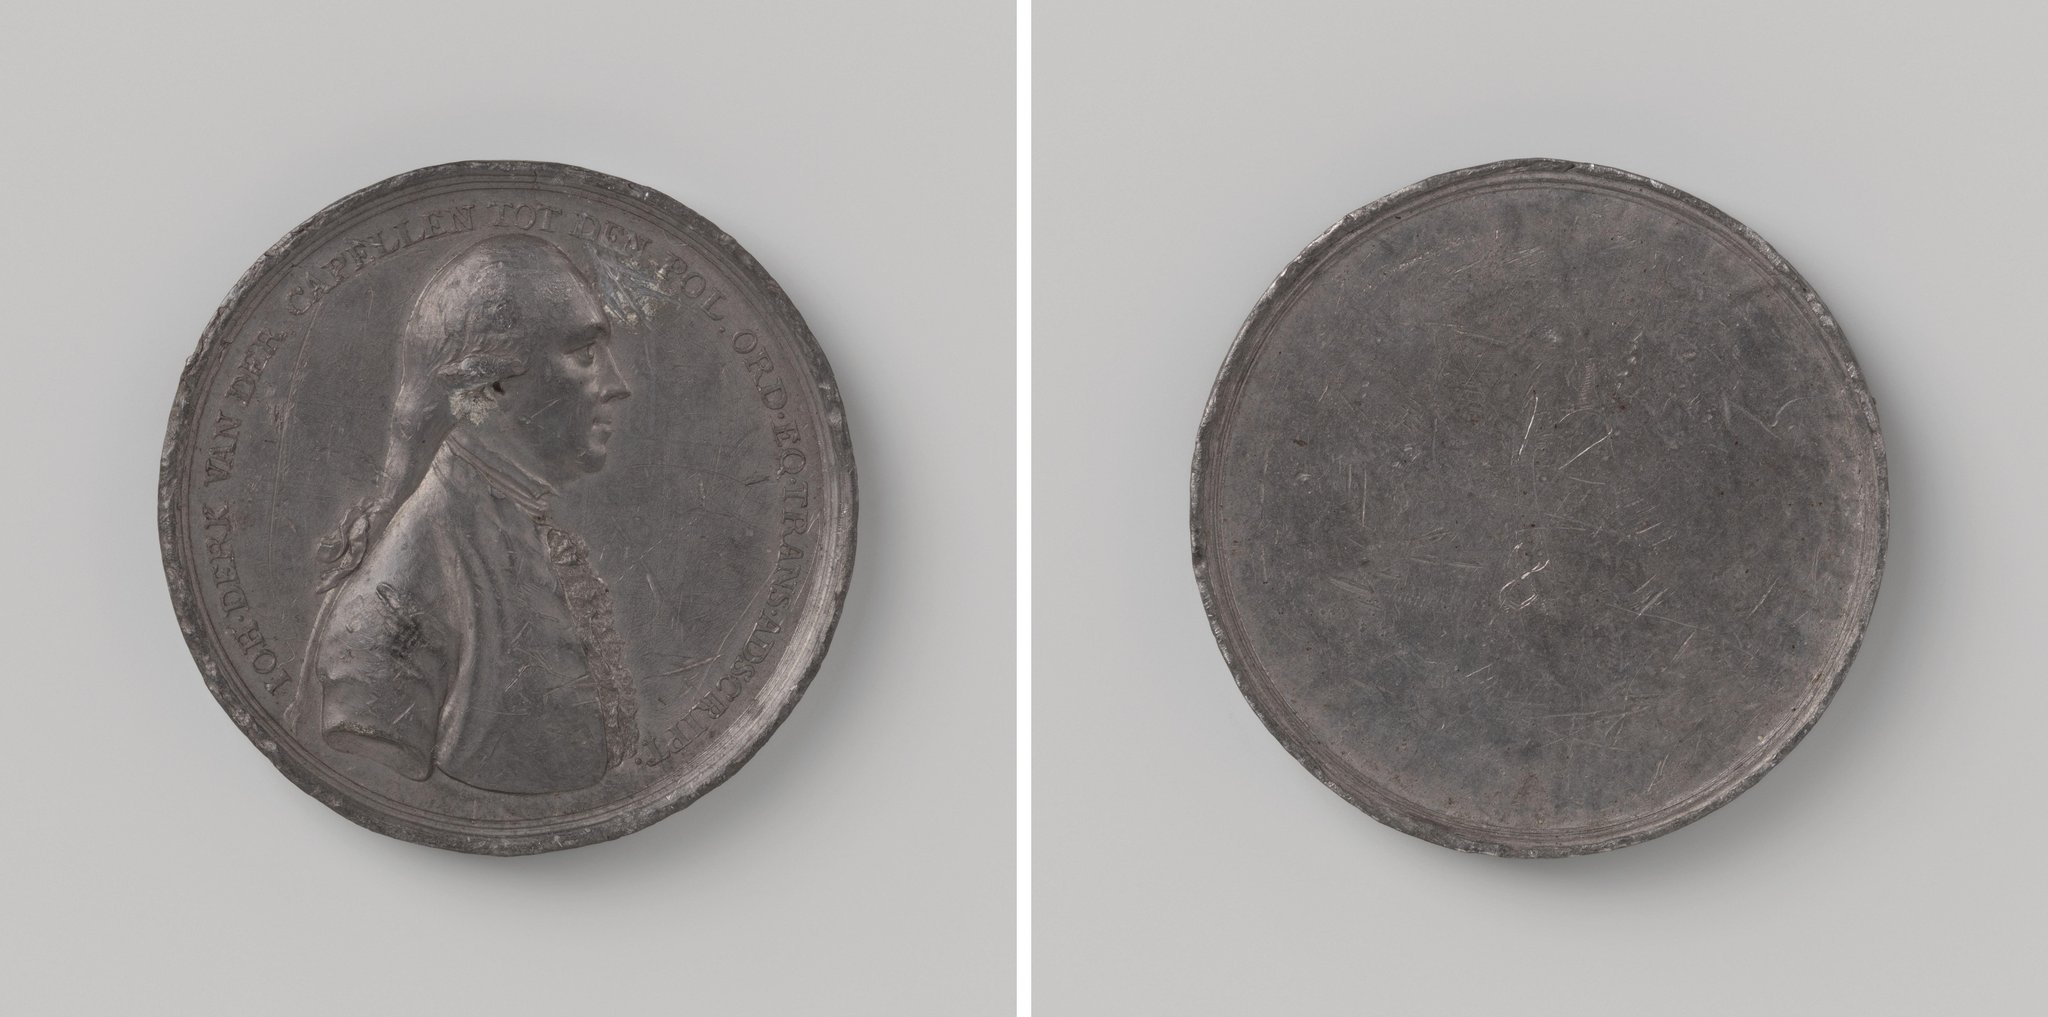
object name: history medal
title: Joan Derk van der Capellen tot den Pol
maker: Anonymous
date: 1782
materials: lead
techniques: striking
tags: politician, joan derk van der capellen tot den pol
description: Eenzijdige loden penning. Voorzijde: borststuk man binnen omschrift. Keerzijde: blanco